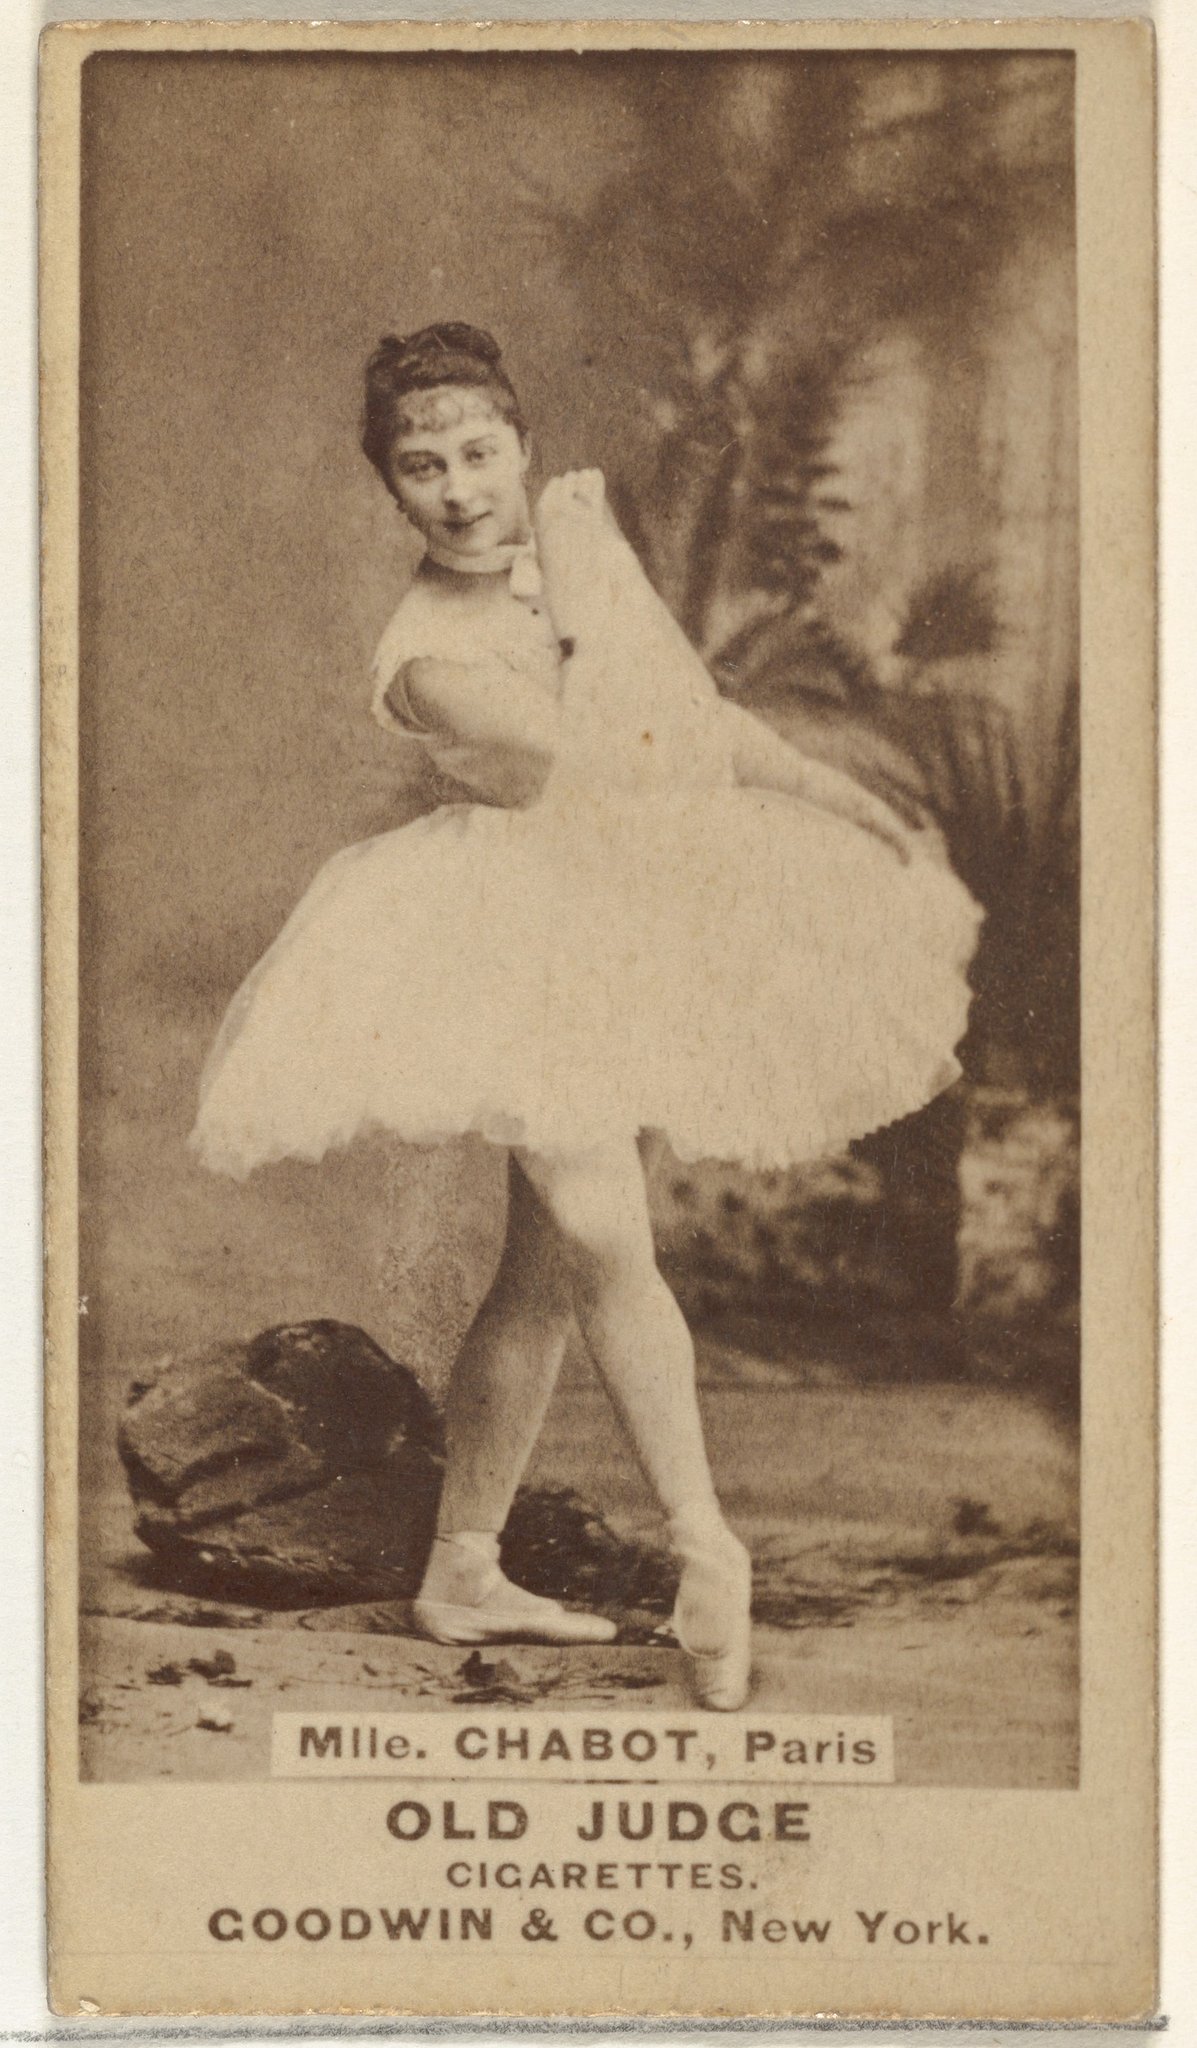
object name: photograph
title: Mlle. Chabot, Paris, from the Actors and Actresses series (N171) for Old Judge Cigarettes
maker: goodwin & company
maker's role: publisher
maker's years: 1850-1950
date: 1886-1890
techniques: albumen silver print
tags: portraits,women,actresses